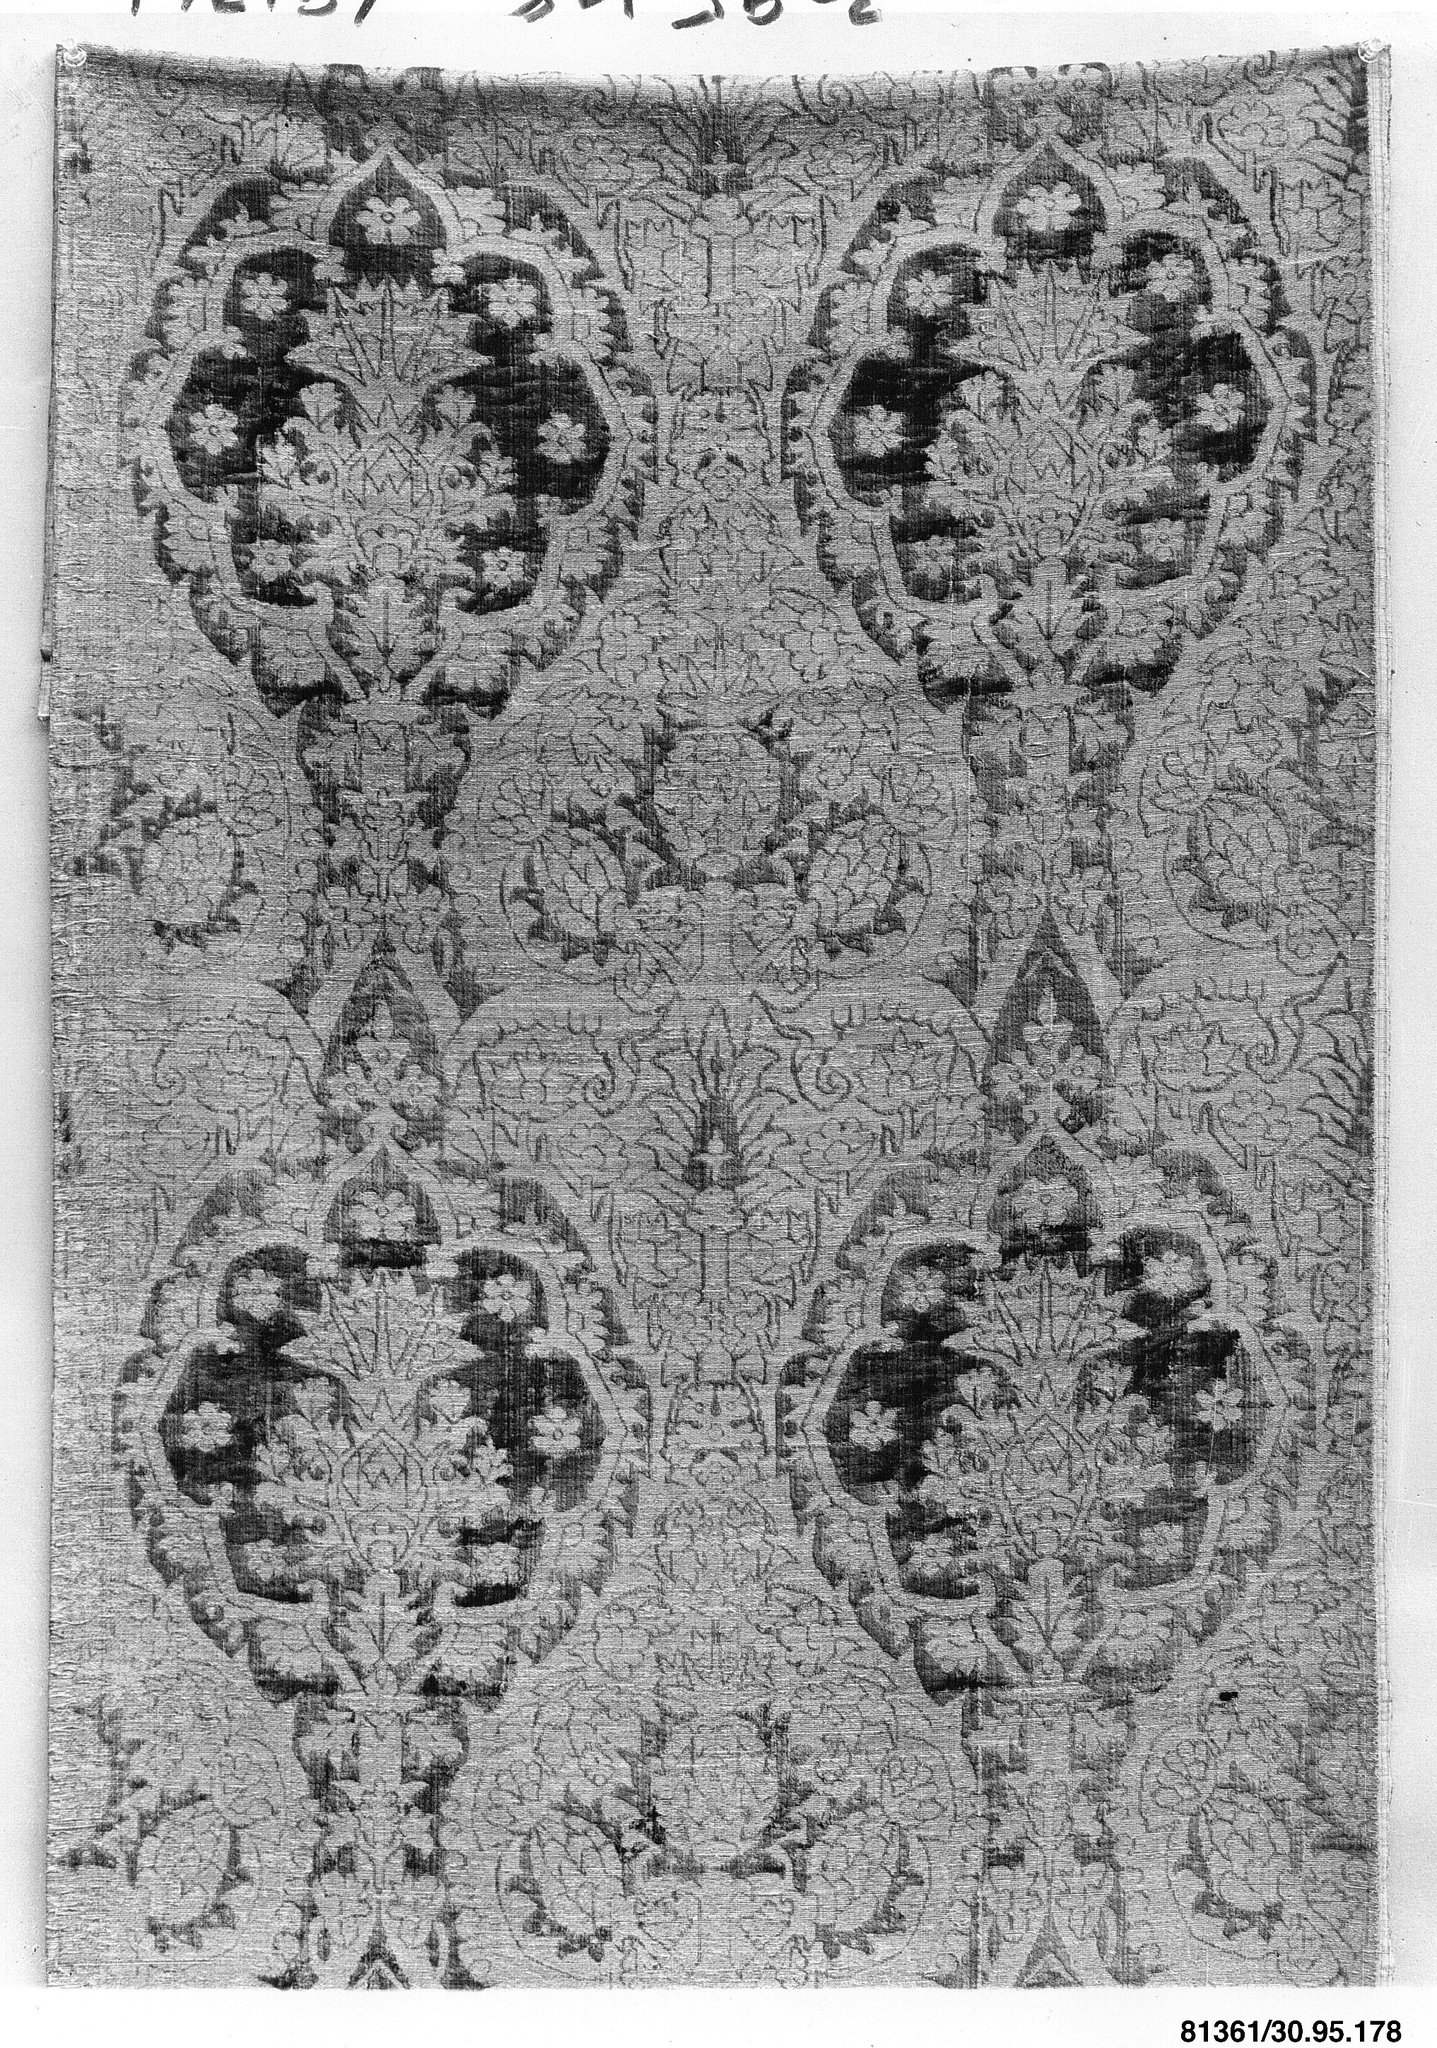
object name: piece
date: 1500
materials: metal thread, silk